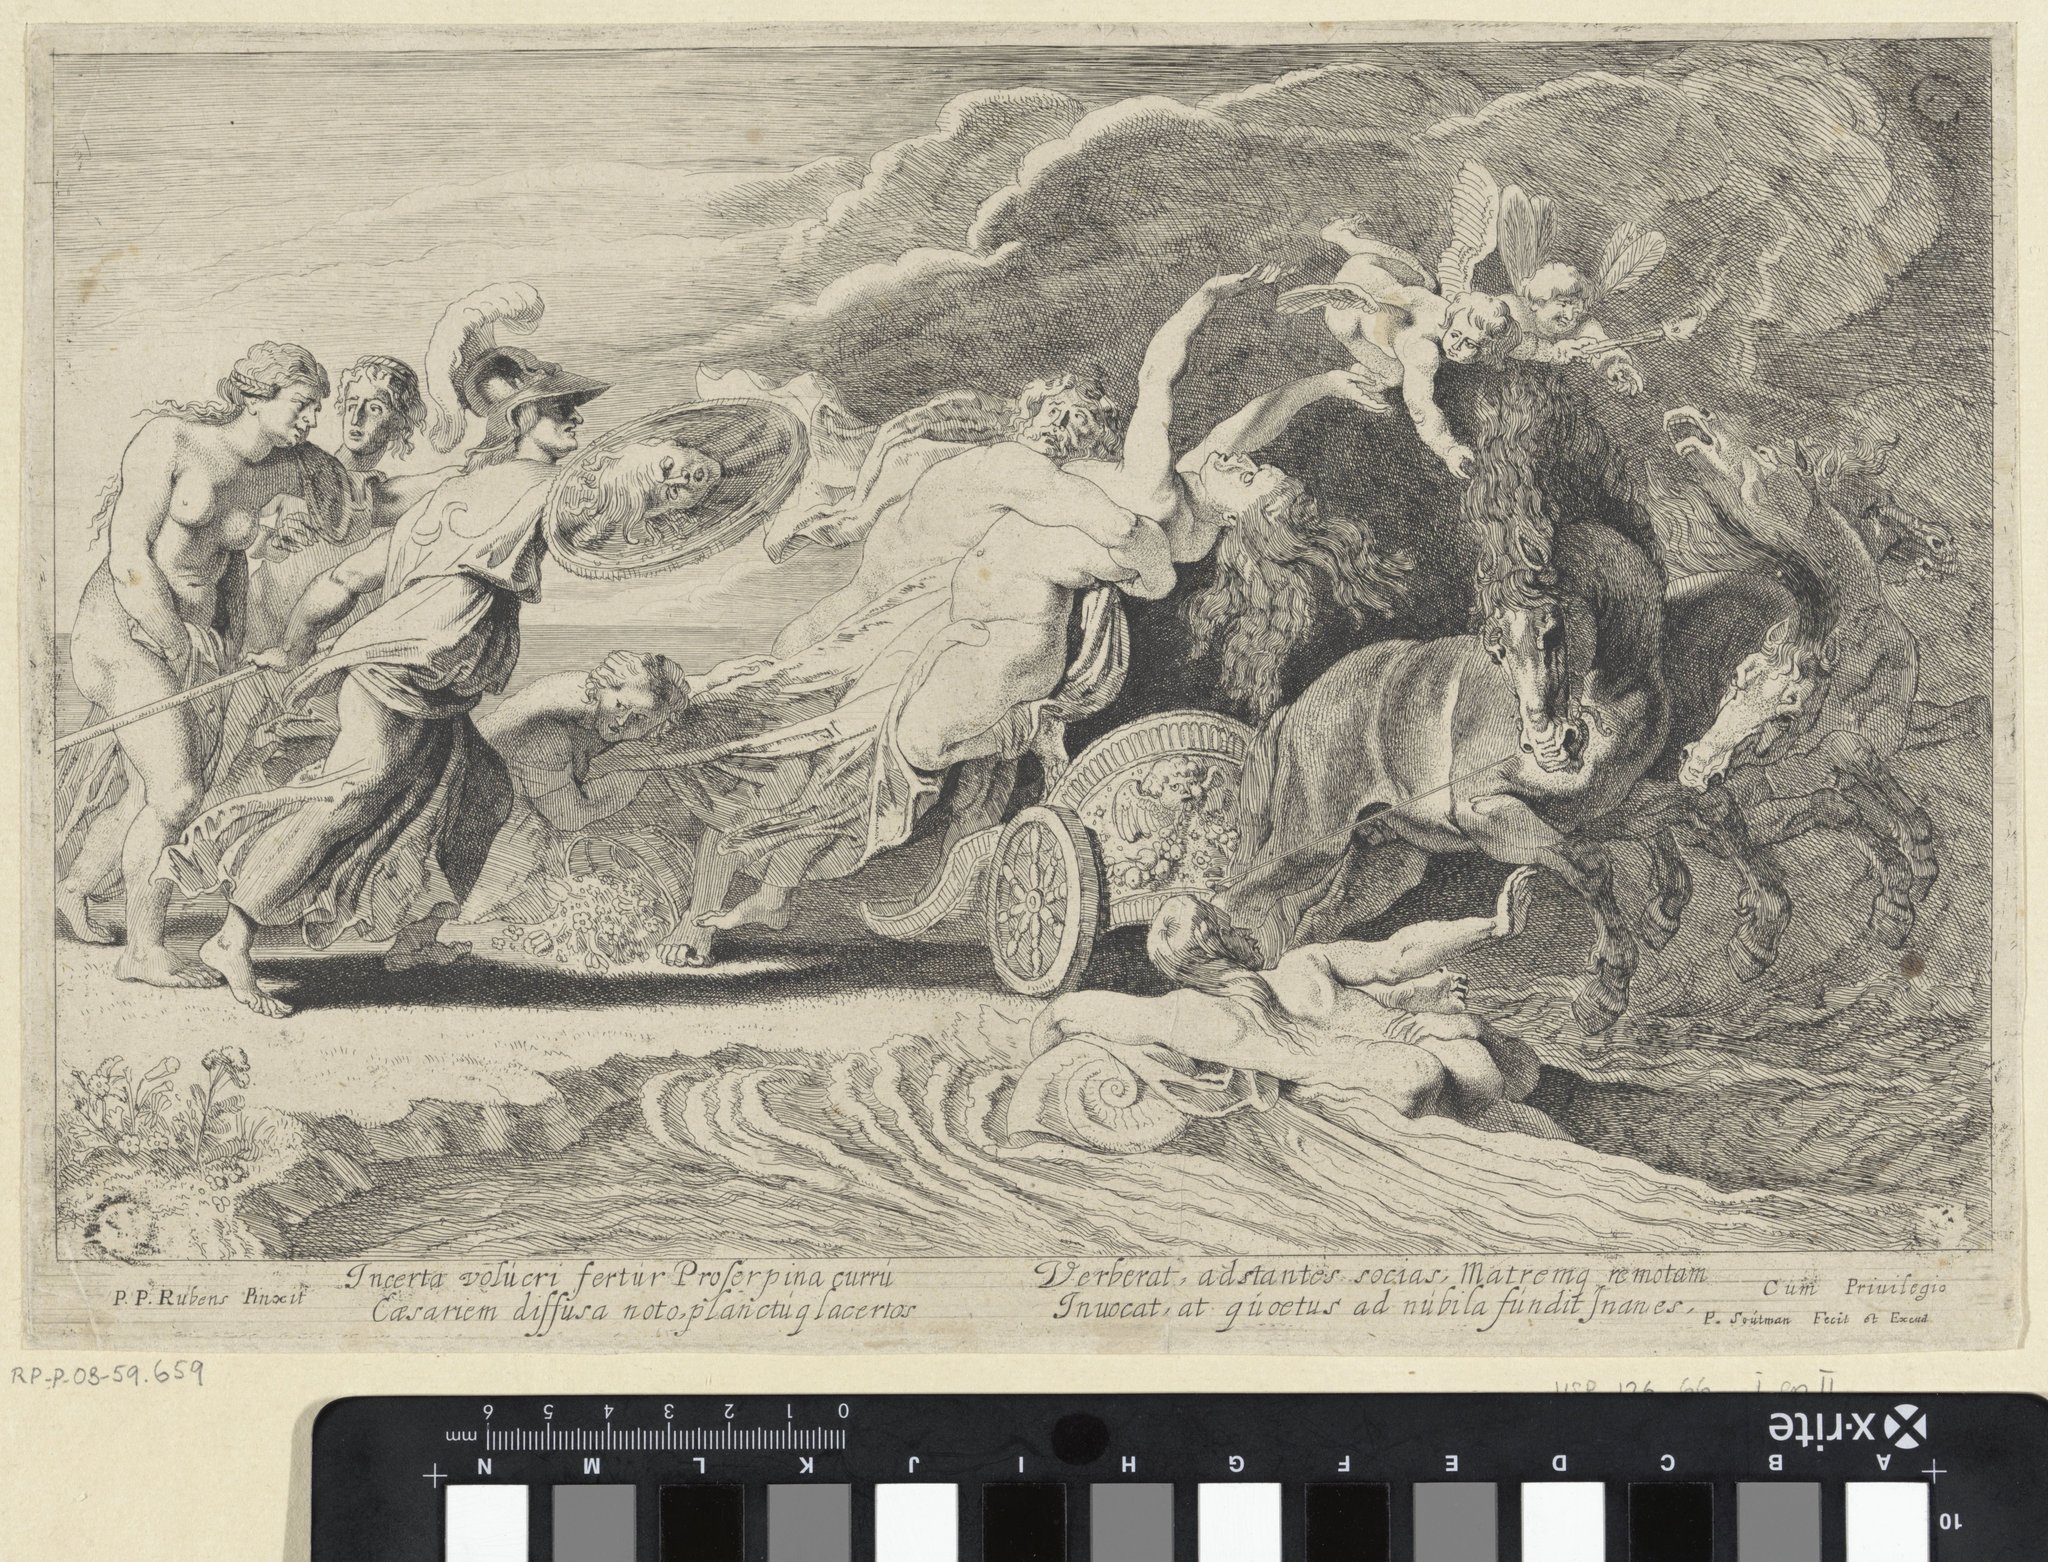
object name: print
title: Roof van Proserpina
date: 1616-1657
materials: paper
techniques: engraving, etching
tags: the rape of proserpina (by pluto in his chariot); possibly with diana and minerva trying to rescue her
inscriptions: collector's mark: Lugt 240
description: Pluto sleept Proserpina, de dochter van Ceres, in zijn wagen. Vanaf het strand kijken de nimfen toe. Minerva probeert de ontvoering te voorkomen. Onder de afbeelding vier versregels in het Latijn. Genummerd "6".